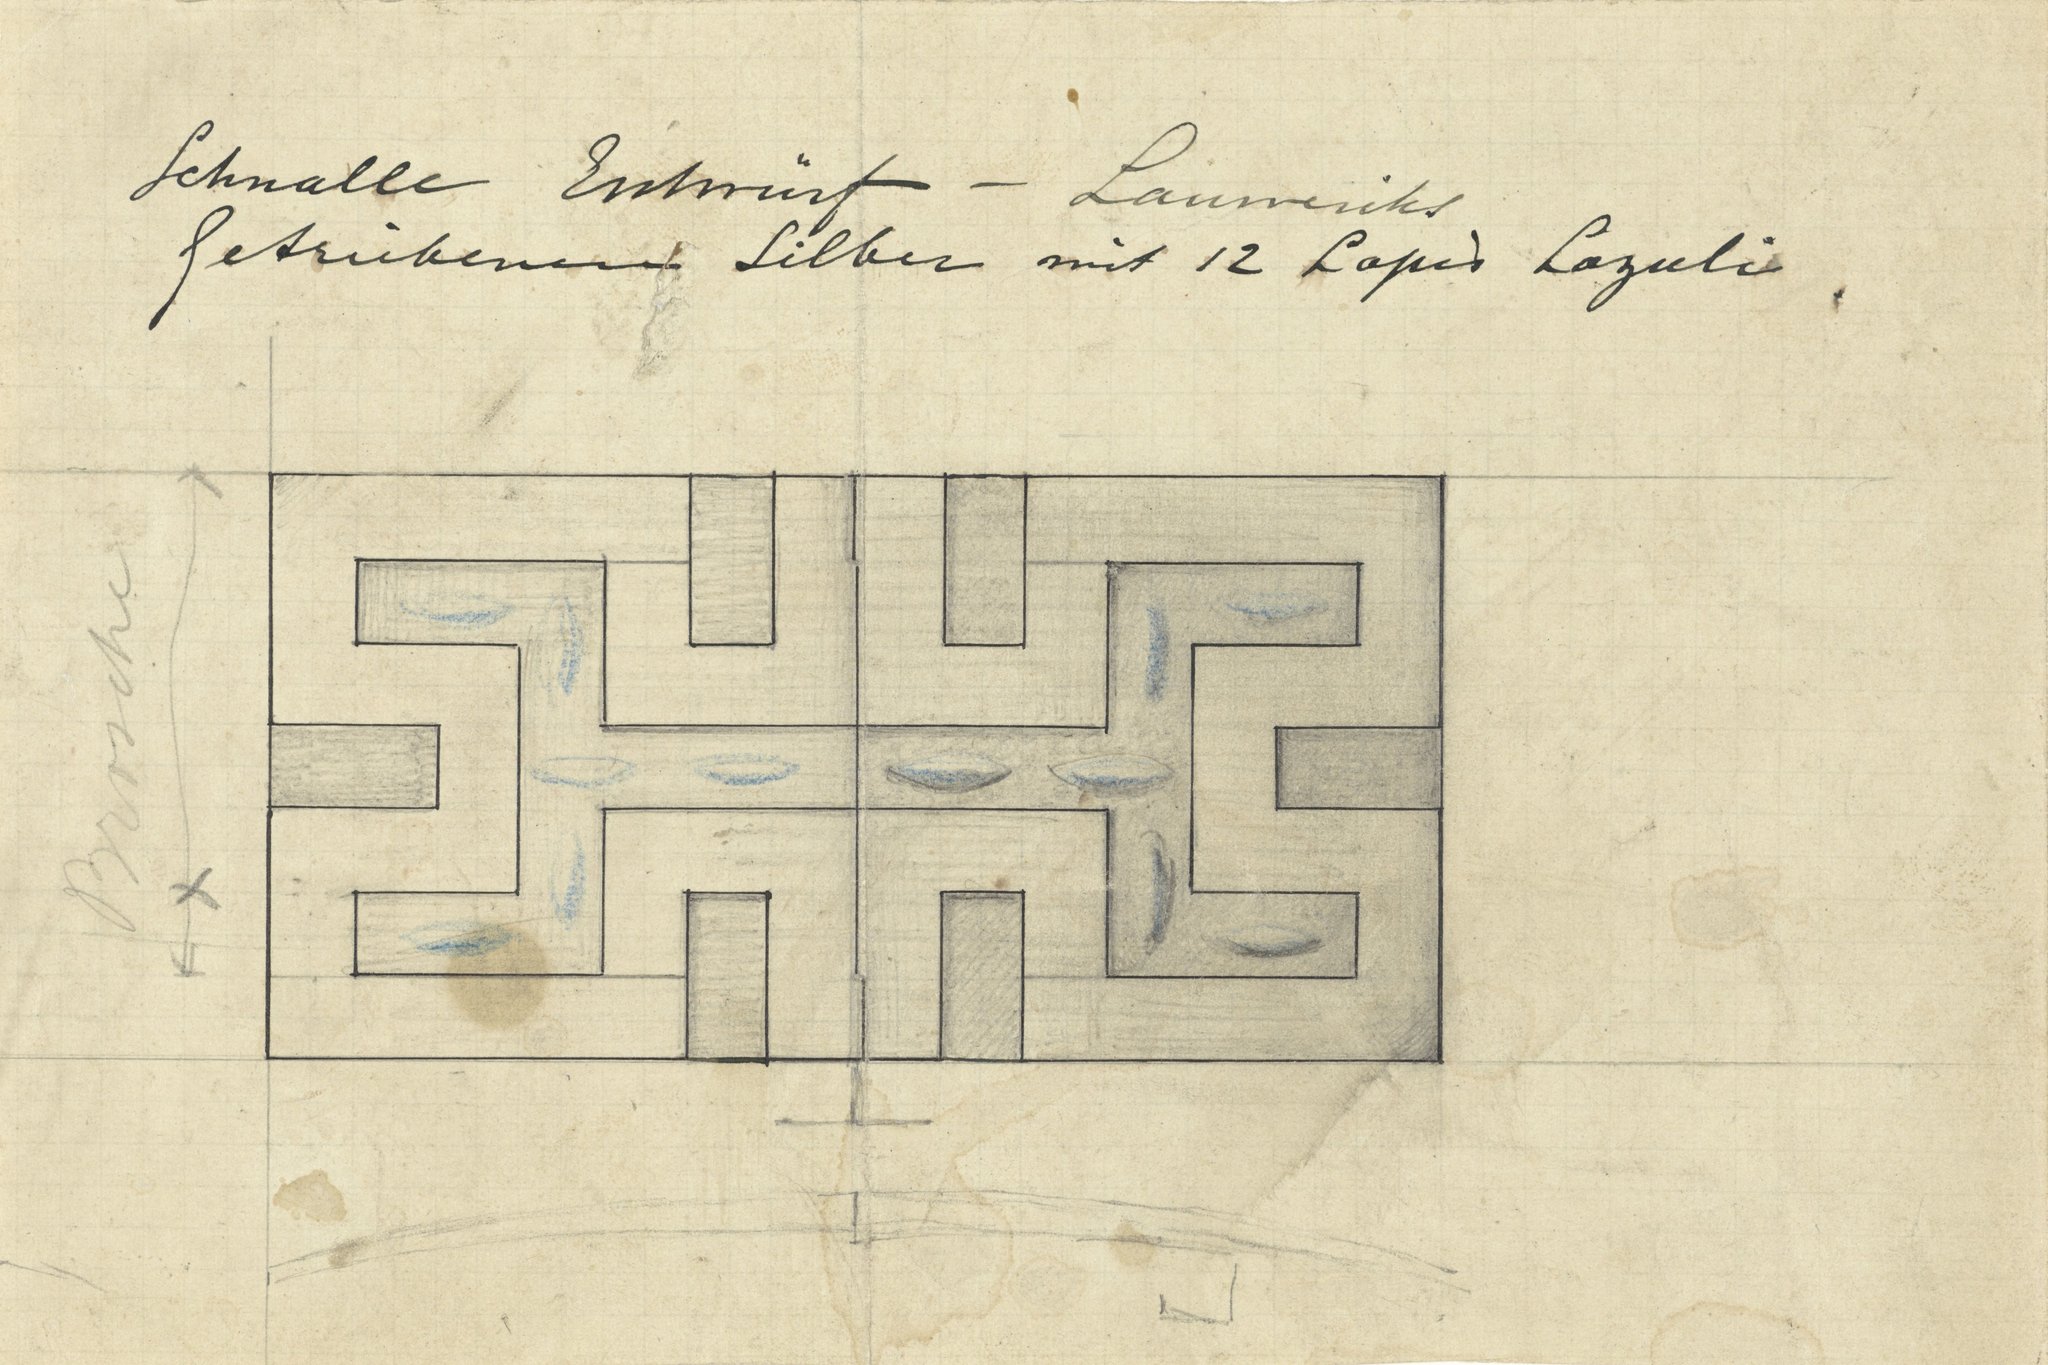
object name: design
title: Ontwerp voor een gesp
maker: mathieu lauweriks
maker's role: designer, draughtsman, print maker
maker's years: 1864-1932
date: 1874-1932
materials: ink, pencil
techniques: pen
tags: buckle